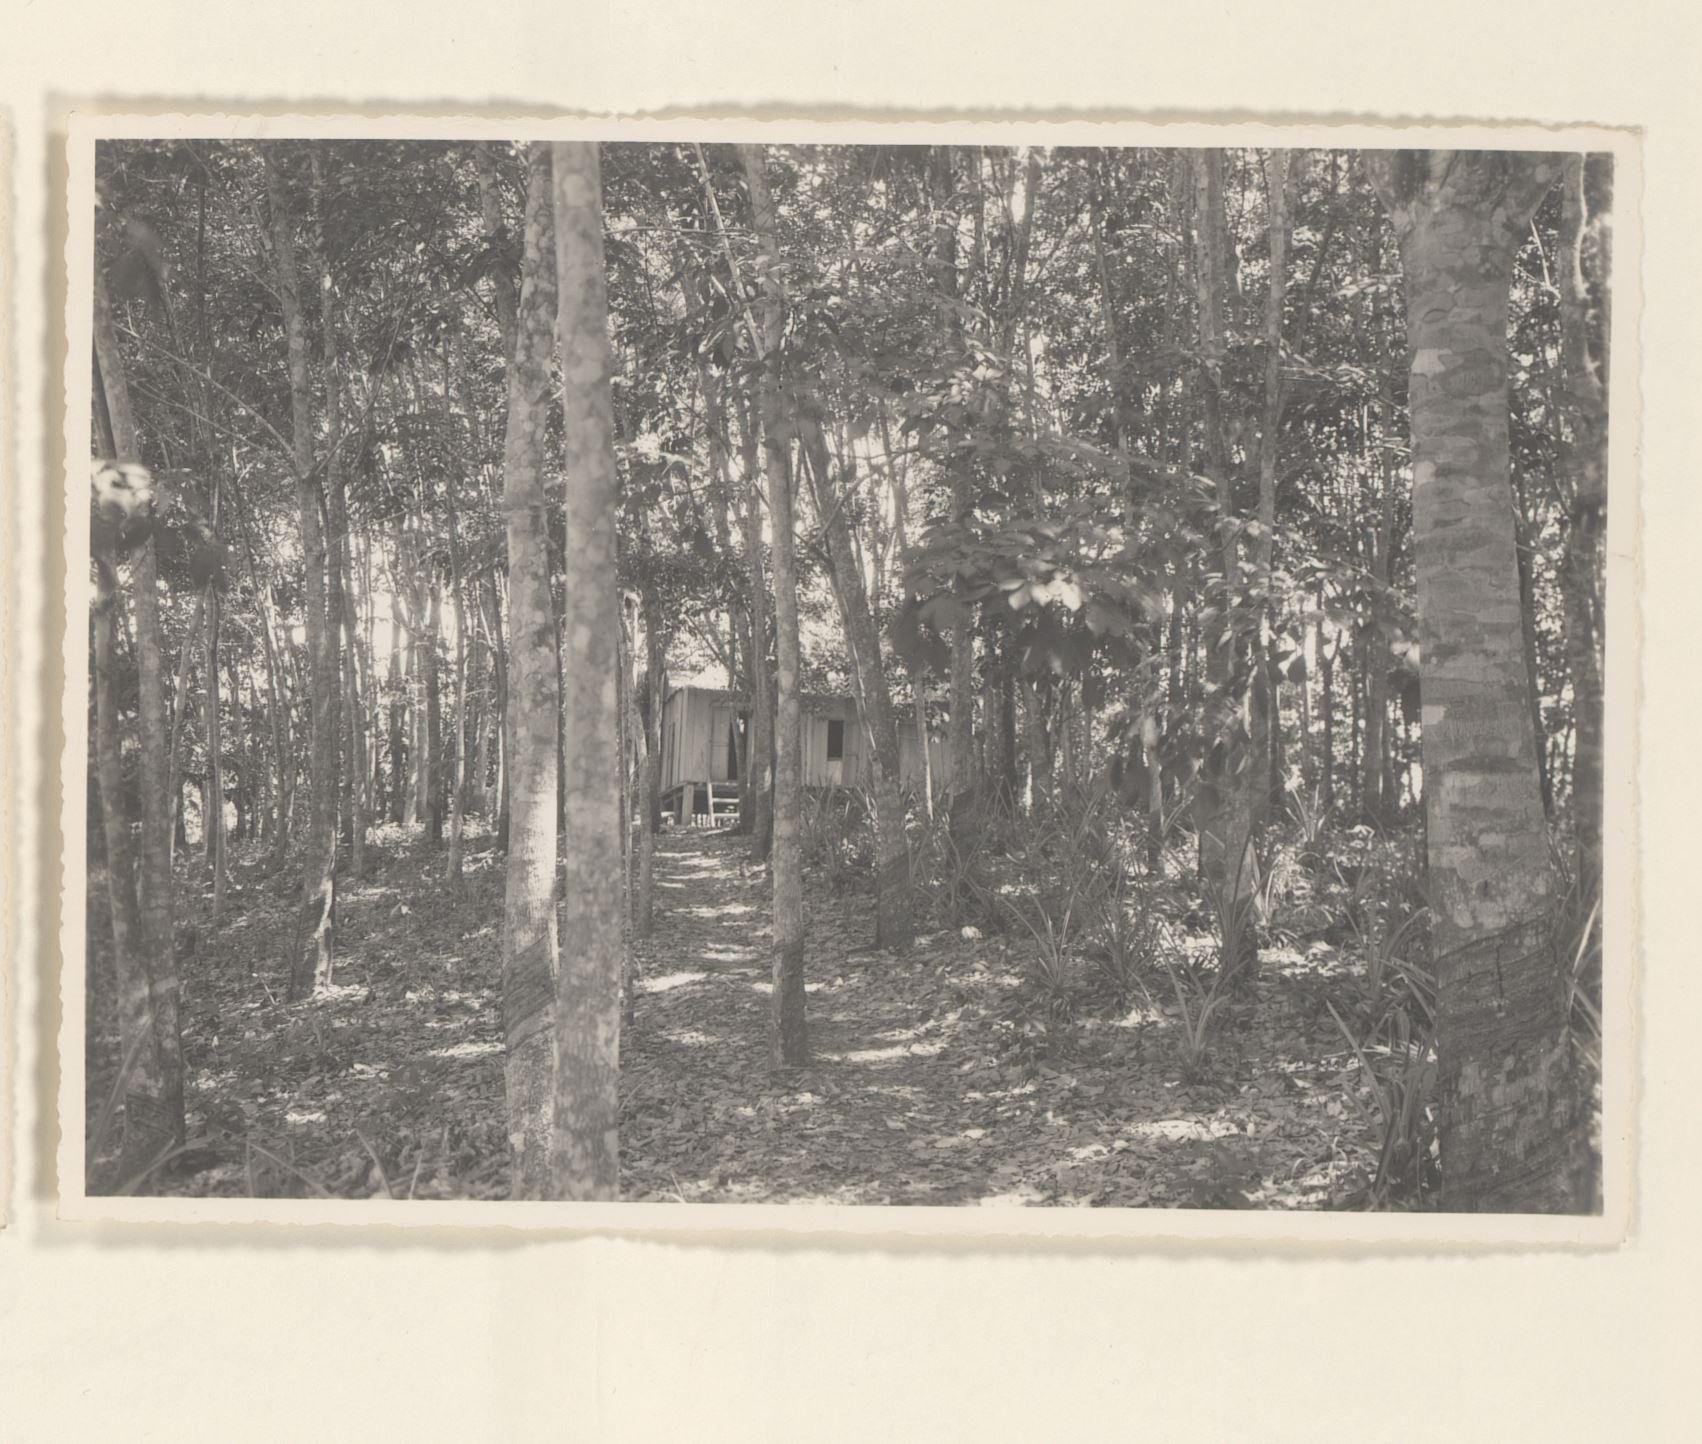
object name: photograph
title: Lokale rubbertuin Marbau, 1938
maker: Anonymous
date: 1908-1938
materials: photographic support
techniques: gelatin silver print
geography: sumatra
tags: plantation, (non-fruit) products of plants or trees: rubber, sumatra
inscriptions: inscription: ‘Inl: rubbertuin Marbau. Augs '38’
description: Lokale dorpsrubbertuin bij Marbau, augustus 1938. Tweede afdruk, los in melinexhoesje, van een foto ingeplakt op albumblad 15. Onderdeel van het fotoalbum over de plantages Pernantian en Brussel van de Sumatra Caoutchouc Maatschappij op de Oostkust van Sumatra in de jaren 1935-1939.